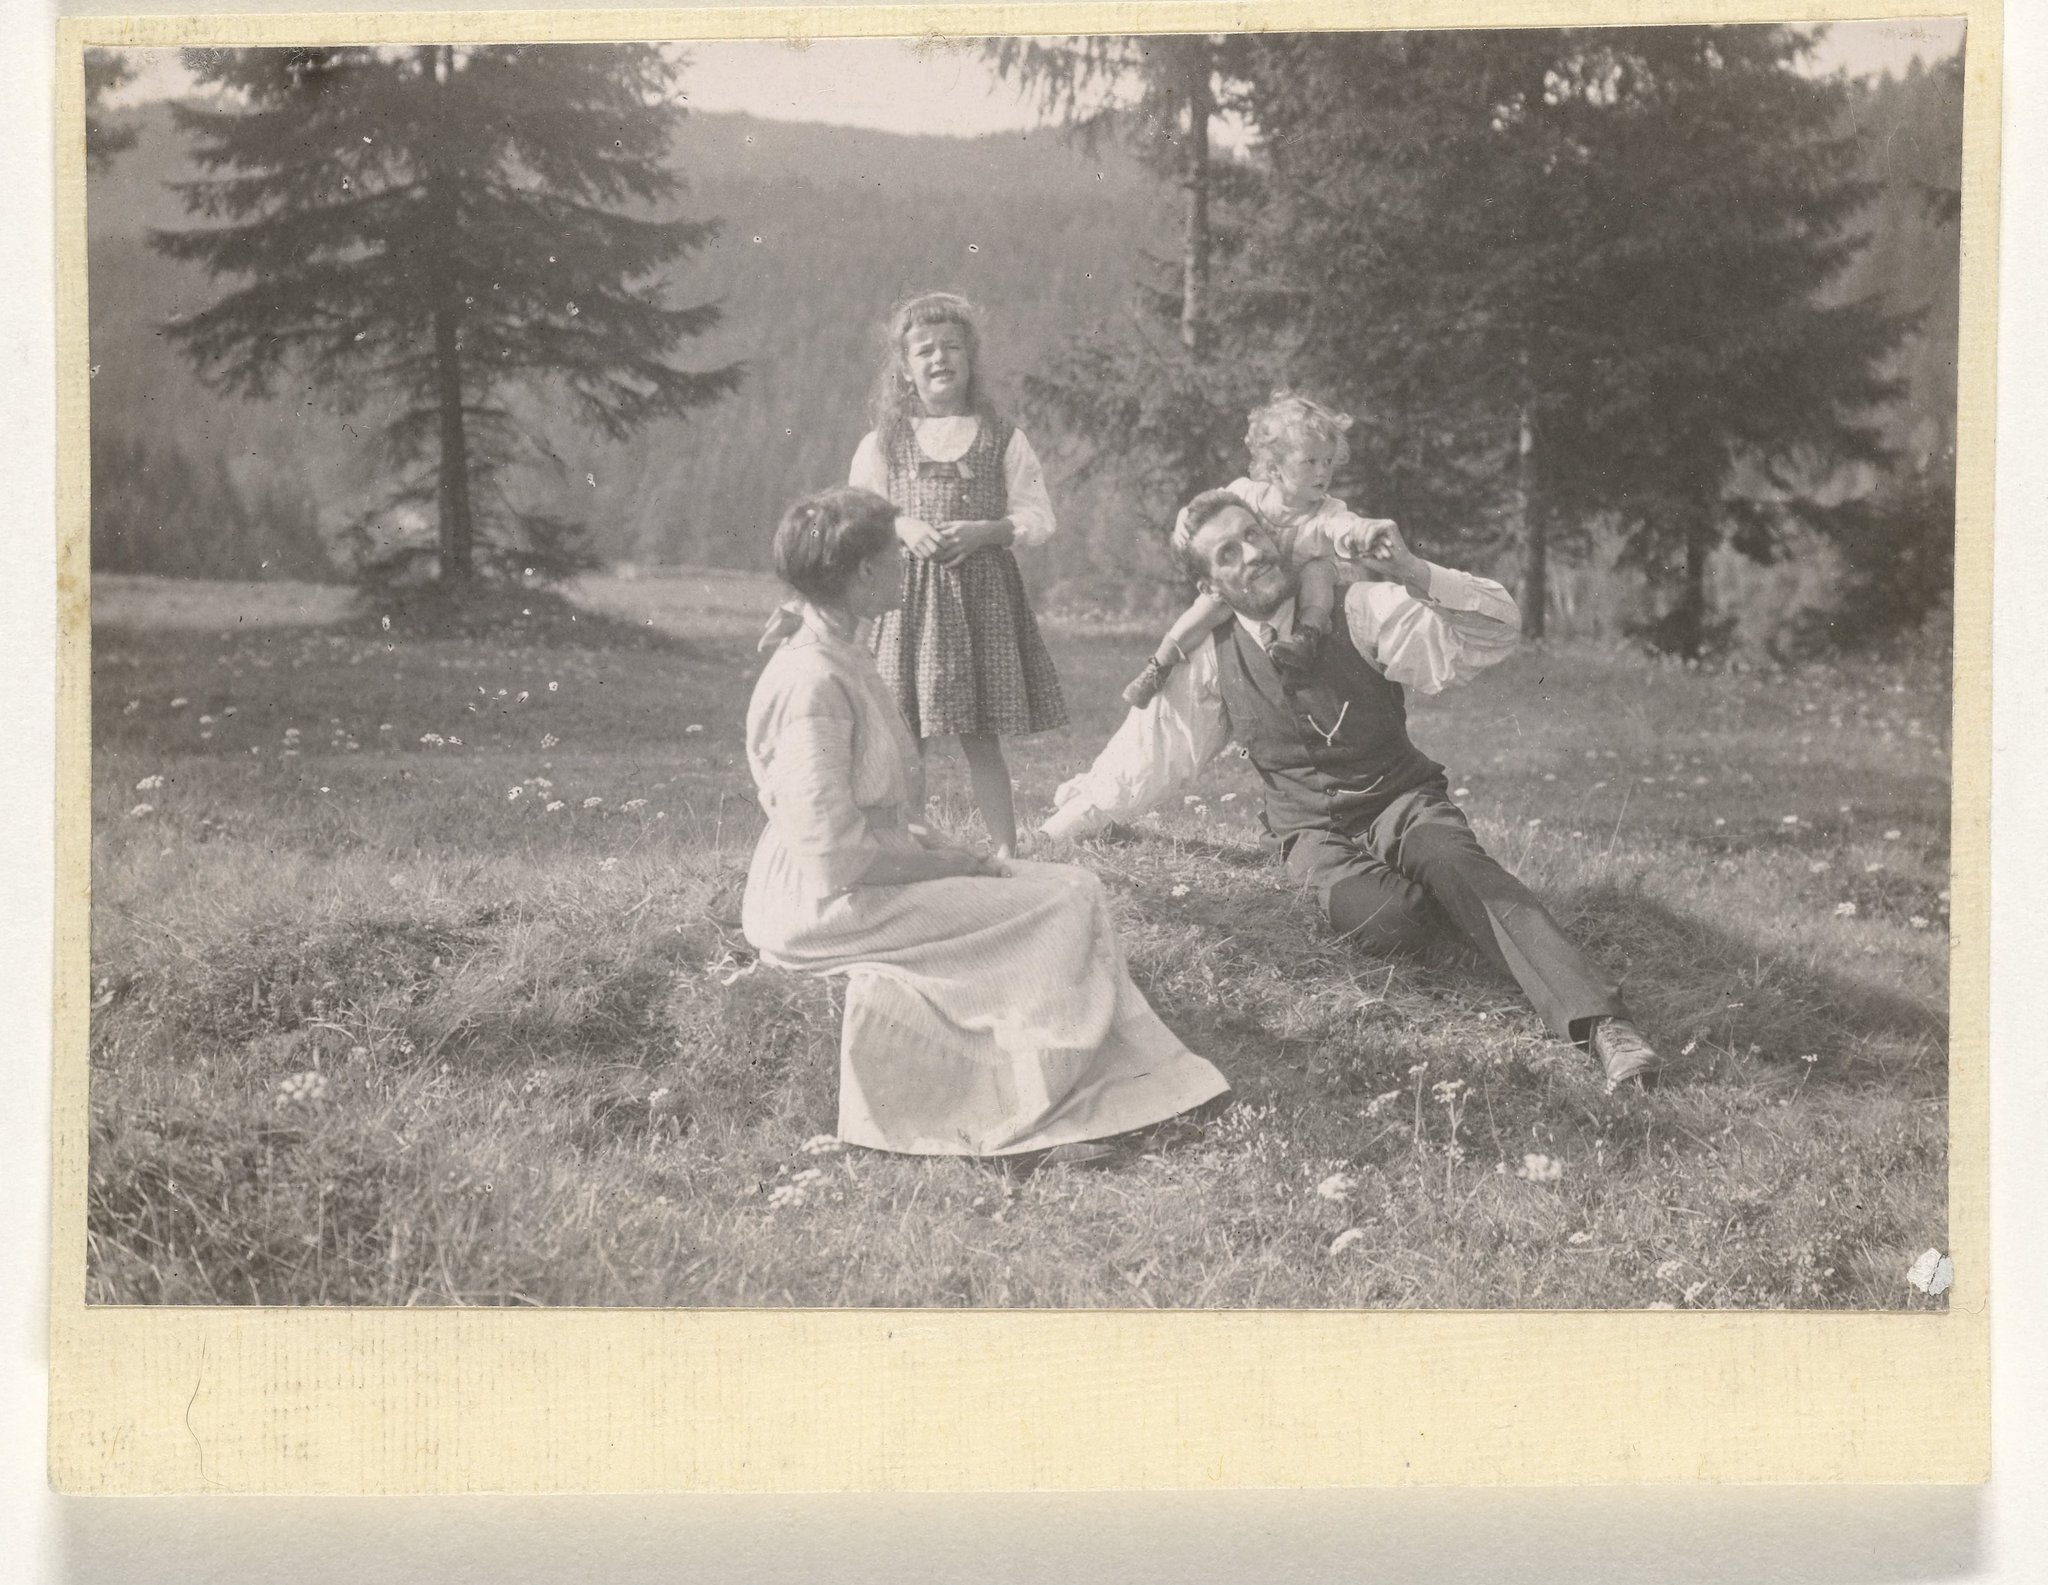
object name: photograph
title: Waldemar Titzenthaler, de fotograaf, met zijn echtgenote Olga en kinderen Marba en Eckart zittend in een veld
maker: waldemar titzenthaler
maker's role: fotograaf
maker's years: 1869-1937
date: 1917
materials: paper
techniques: gelatin silver print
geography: germany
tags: engineer, waldemar titzenthaler, the family travelling, on holiday, portrait, self-portrait of photographer (+ the artist and his family, relatives, etc.), family group, especially parents with their child(ren), germany